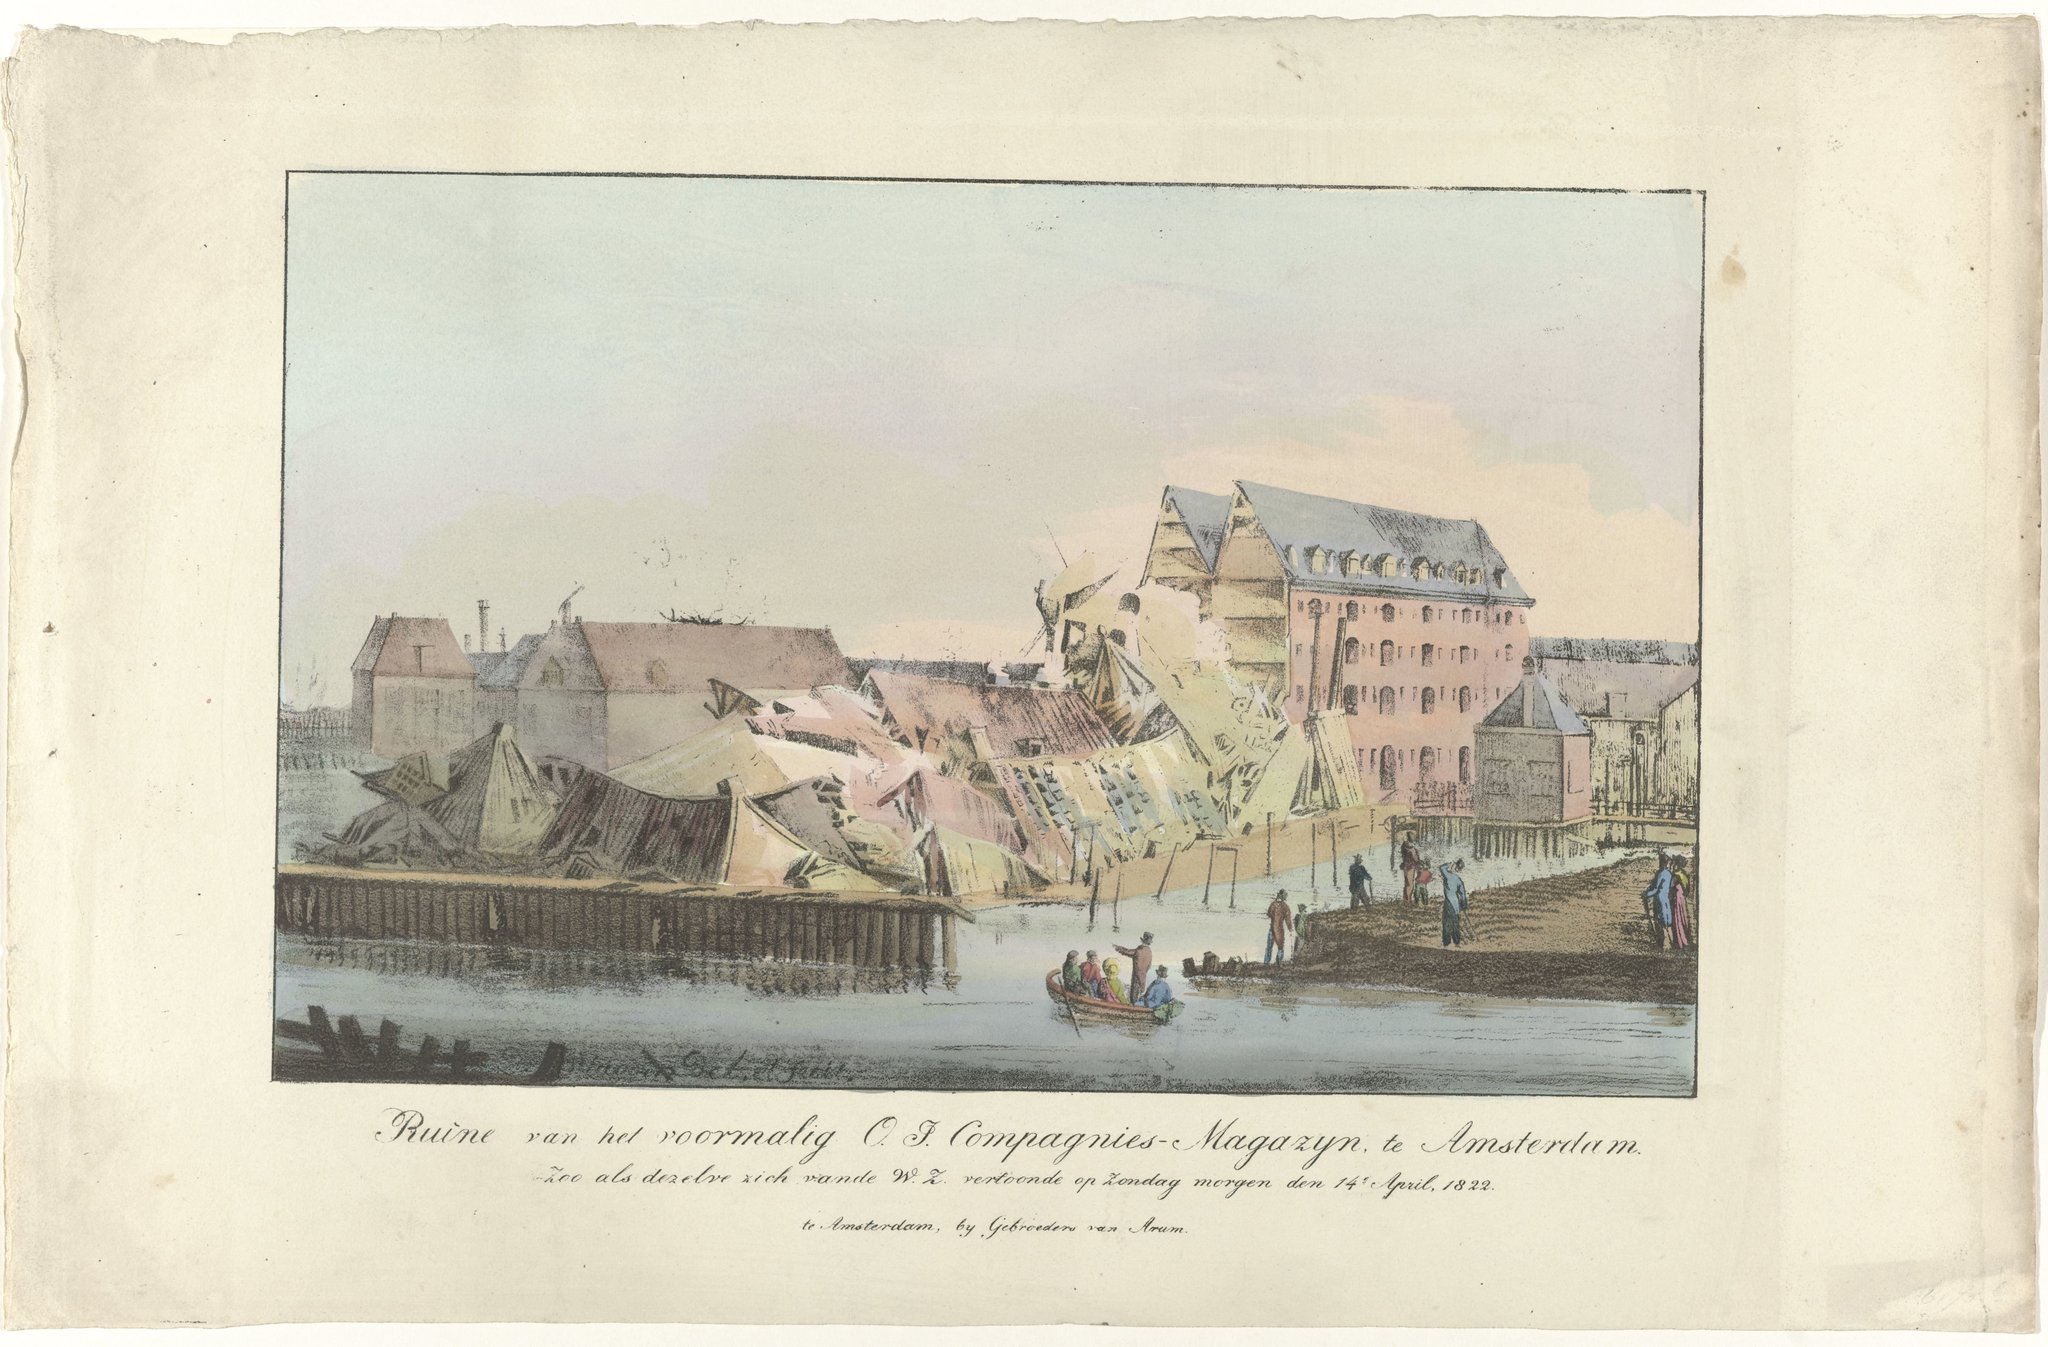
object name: print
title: Ruïne van het Oost-Indisch Zeemagazijn, 1822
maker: jacob plügger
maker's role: print maker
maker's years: 1795-1871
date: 1822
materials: paper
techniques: hand coloring, lithograph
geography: amsterdam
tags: ruin of a building ~ architecture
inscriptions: collector's mark: Lugt 2228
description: Ruïne van het Oost-Indisch Zeemagazijn te Amsterdam, na de instorting op 13-14 april 1822. Gezicht van de westzijde. Zie ook de pendant.